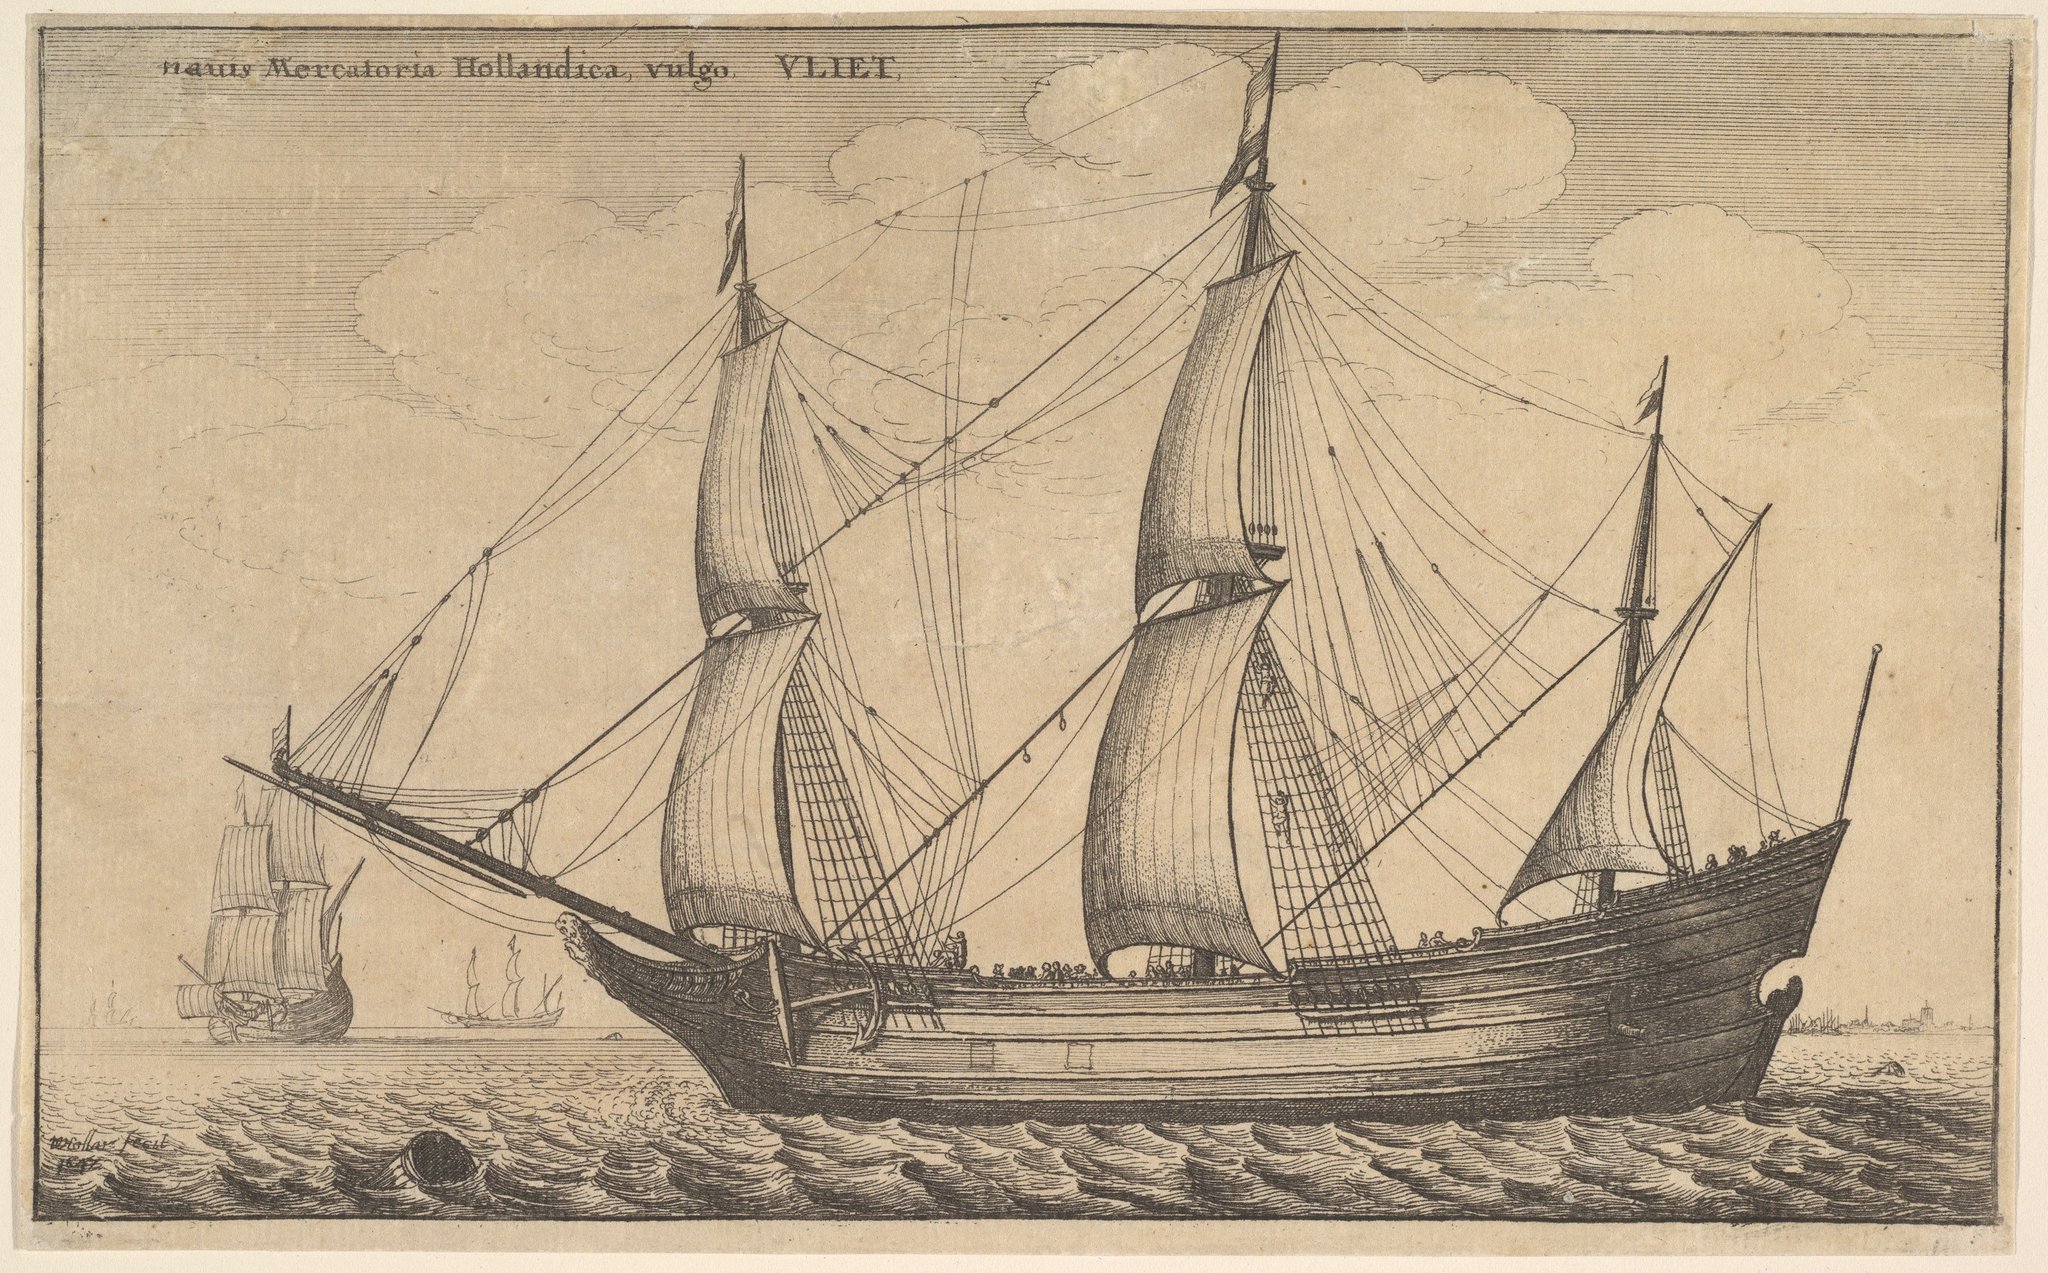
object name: print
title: Naues Mercantoriæ Hollandicæ, vulgo, VLIET (A Dutch freighter)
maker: wenceslaus hollar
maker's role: artist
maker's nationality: bohemian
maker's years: 1607-1677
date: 1647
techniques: etching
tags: ships